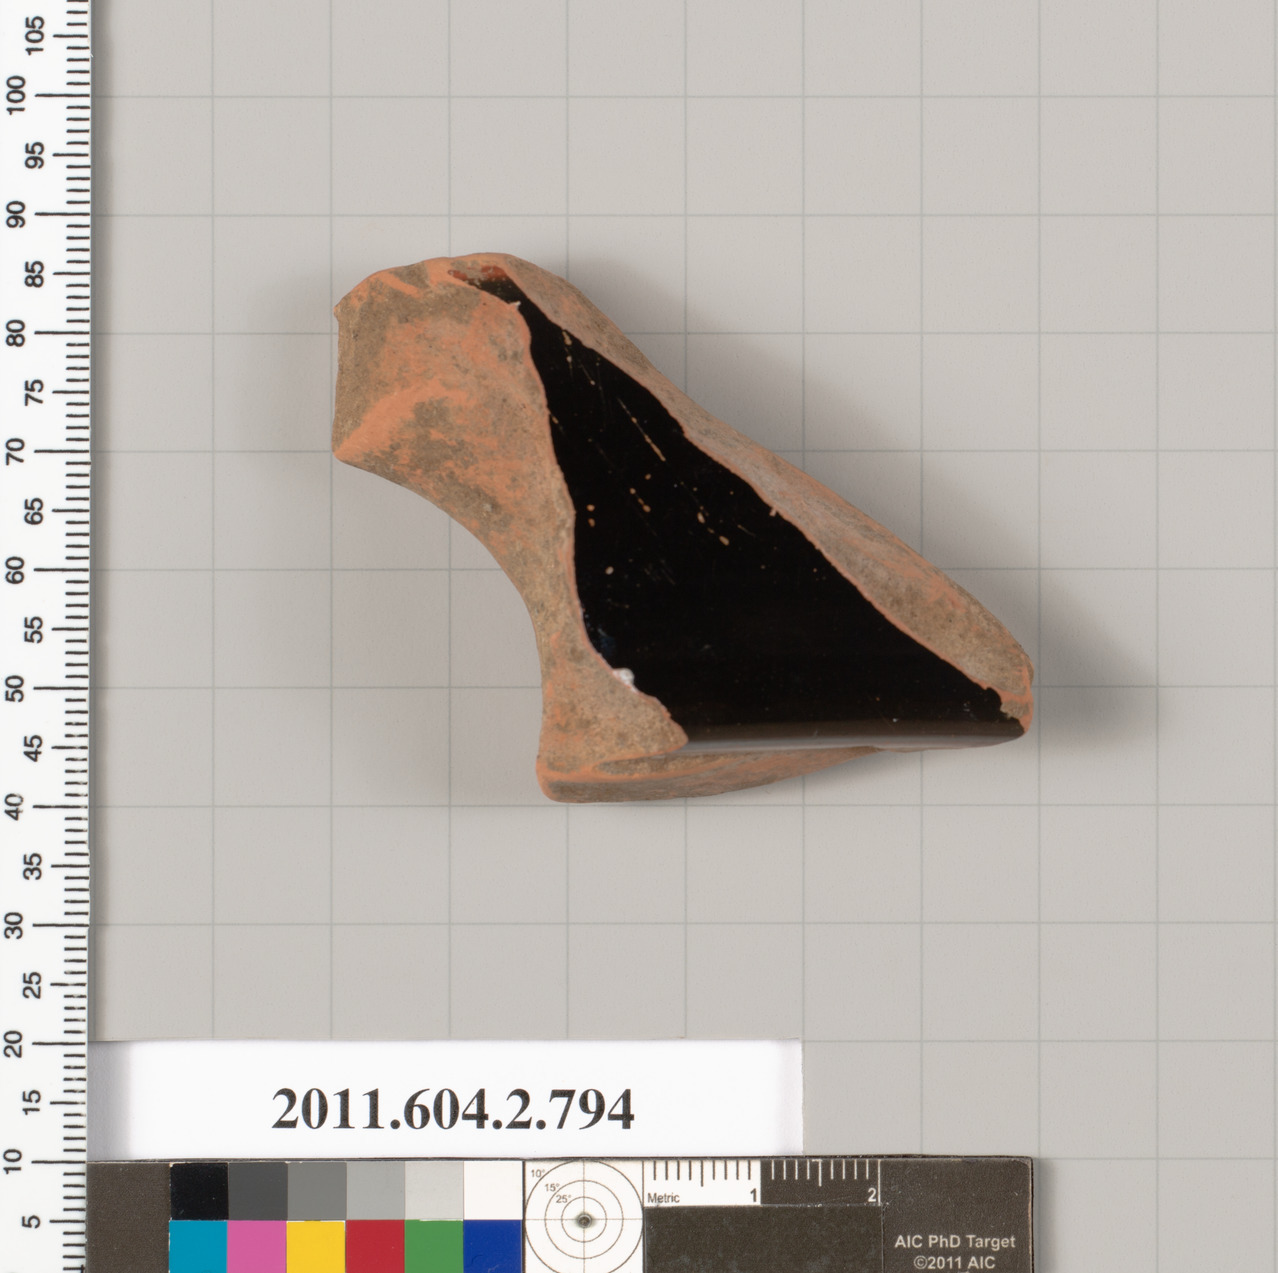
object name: calyx krater fragment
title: Terracotta fragment of a calyx-krater (bowl for mixing wine and water)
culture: greek, attic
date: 600-401 BCE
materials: terracotta